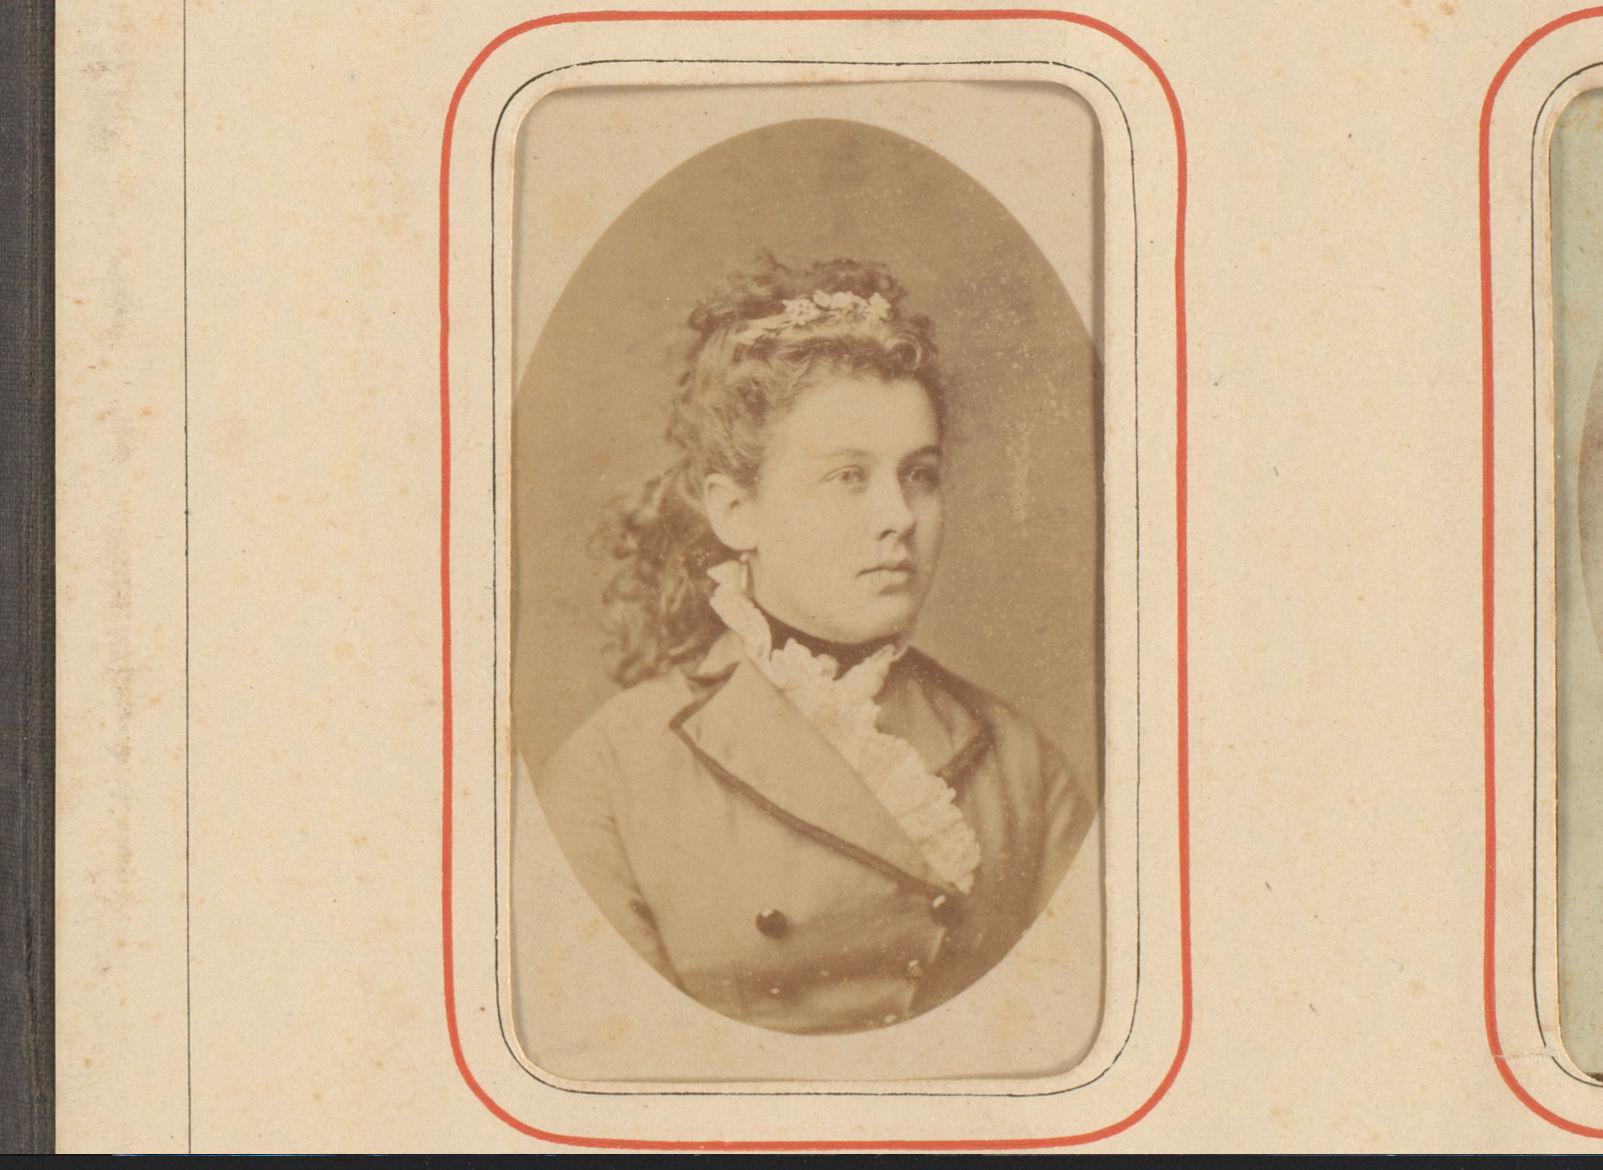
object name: photograph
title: Portret van een onbekende vrouw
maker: bernardus bruining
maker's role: fotograaf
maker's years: 1834-1900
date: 1875-1877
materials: cardboard, paper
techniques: albumen print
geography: leiden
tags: anonymous historical person portrayed - bb - woman